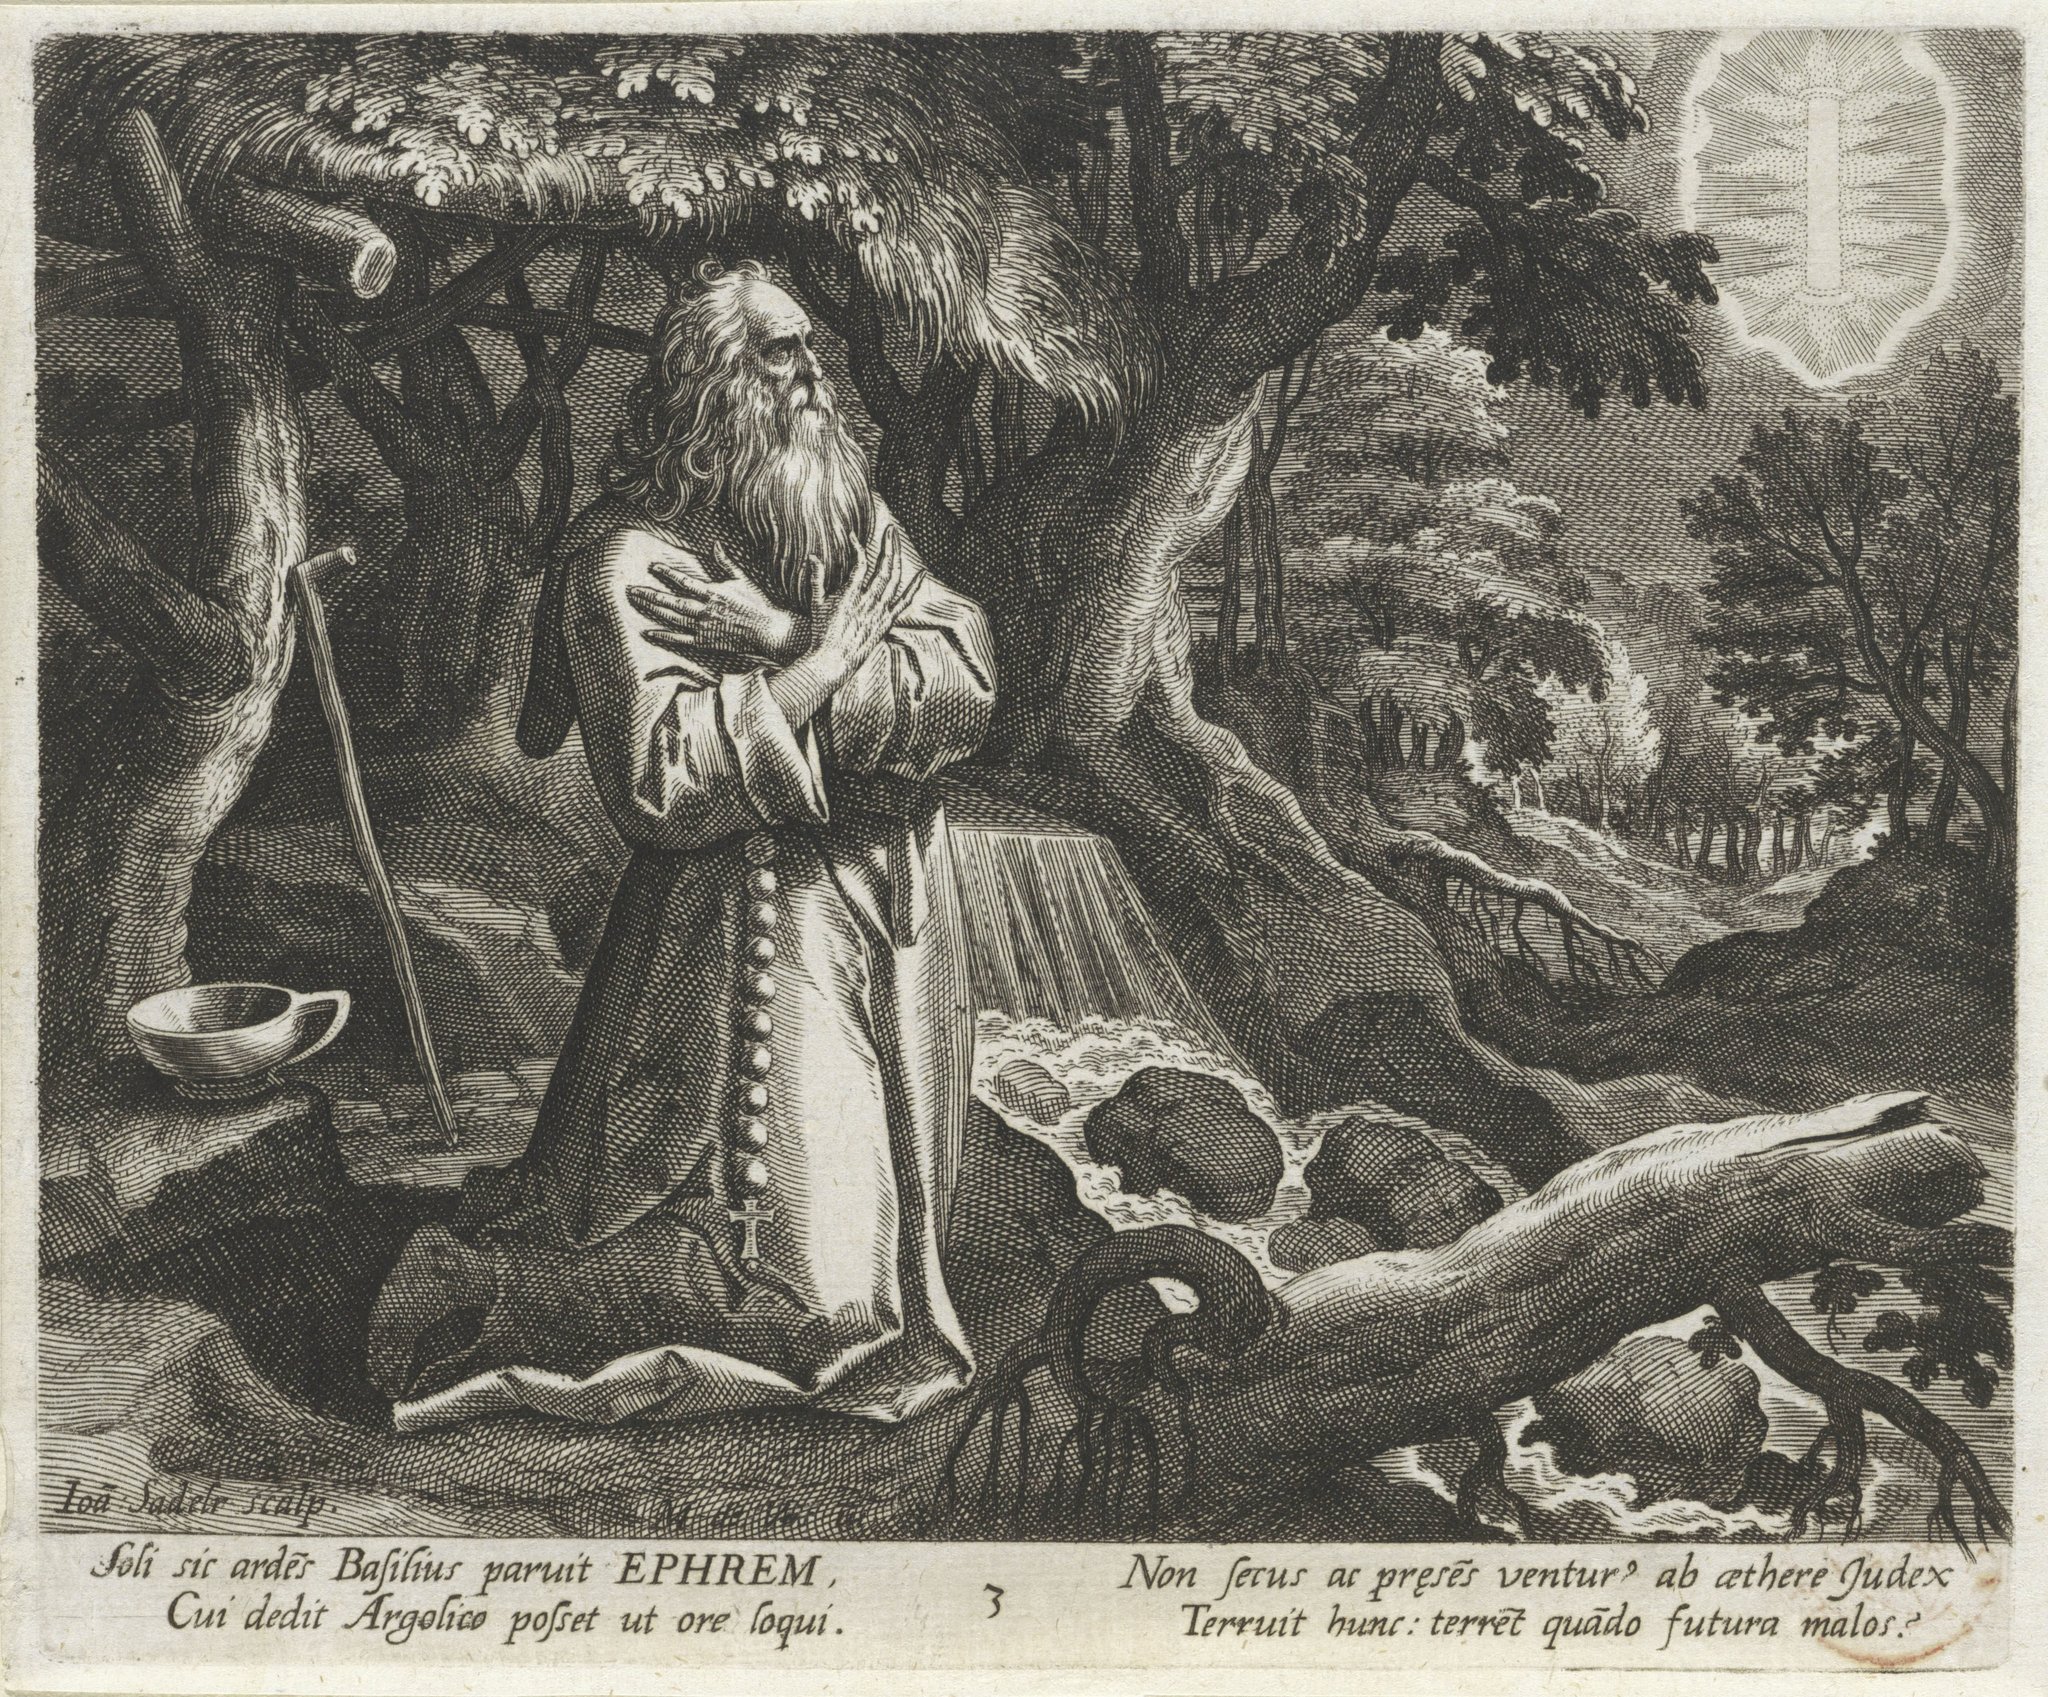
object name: print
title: Mannelijke kluizenaars en heremieten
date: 1594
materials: paper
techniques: engraving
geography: munich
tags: specific aspects ~ st. basil the great, male saints (ephraem) - vision(ephraem), mystic marriage of male saint, waterfall, anchorite, hermit, deciduous forest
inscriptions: collector's mark: Lugt 240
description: De H. Ephraim de Syriër als een vroeg-christelijke kluizenaar, in een hut in een boslandschap. Hij knielt voor het visioen van een vurige zuil die aan de hemel verschijnt (de aankonidiging van de H. Basilius de Grote).